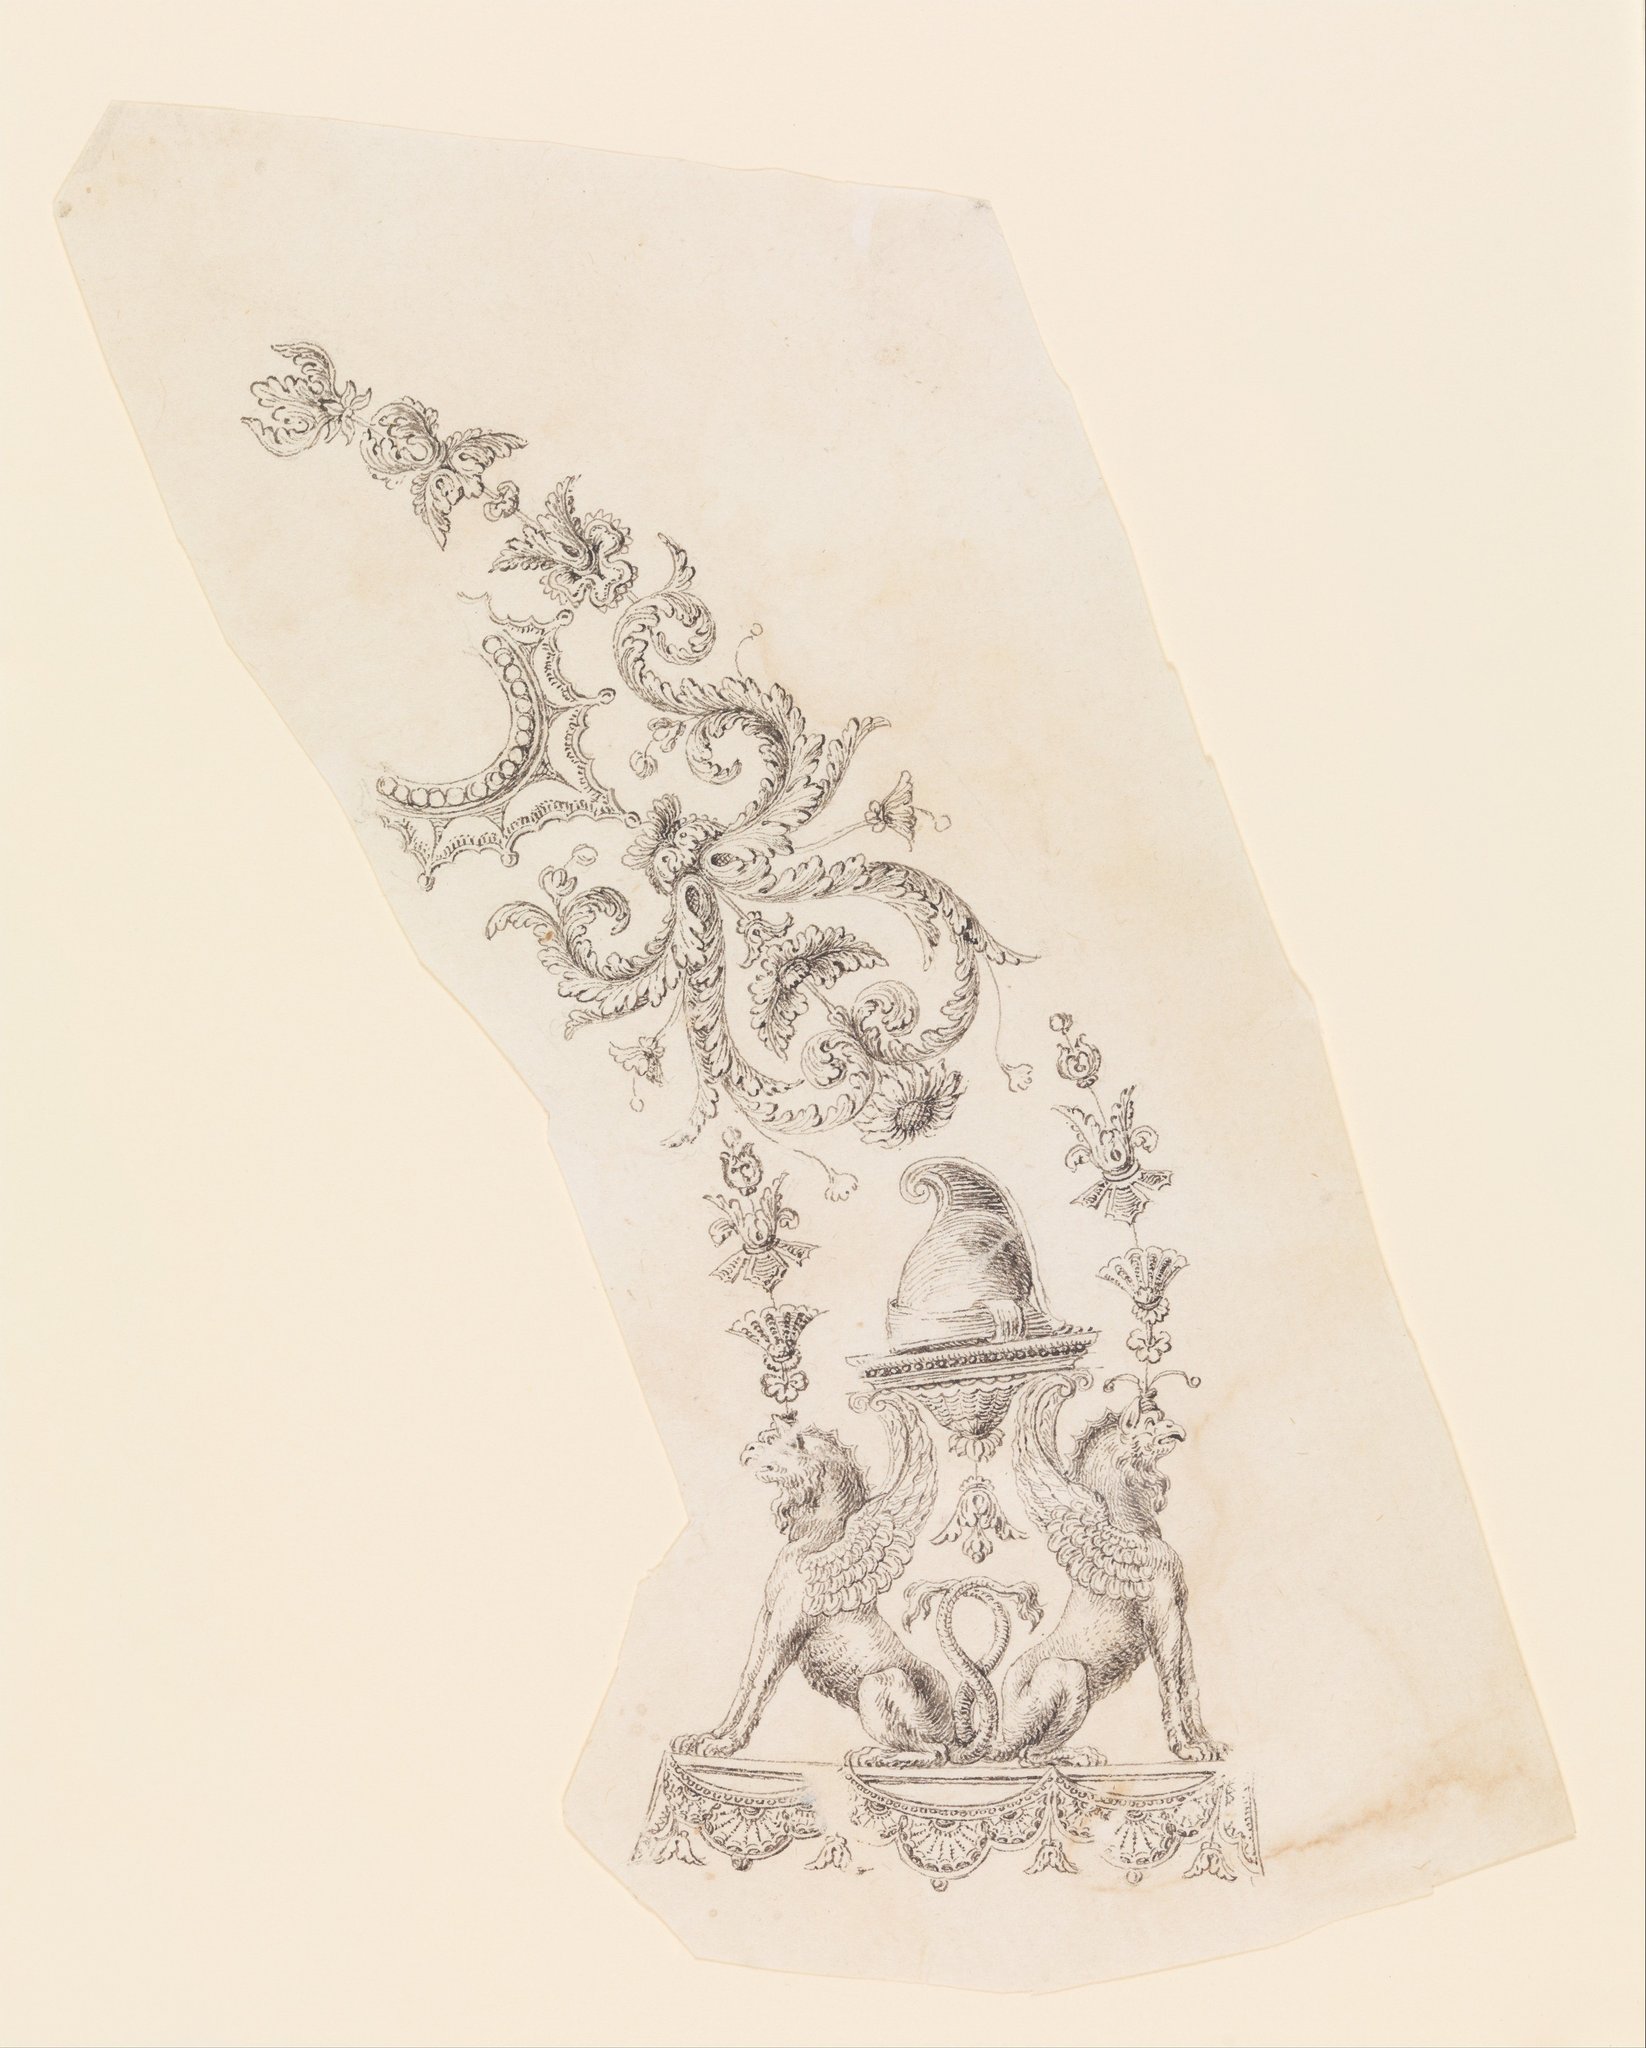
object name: drawing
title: Design for the Decoration of Firearms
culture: french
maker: nicolas noël boutet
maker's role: designer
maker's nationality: french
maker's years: 1761-1833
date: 1795-1805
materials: ink, paper, pencil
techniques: wash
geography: france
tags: ornament,griffins